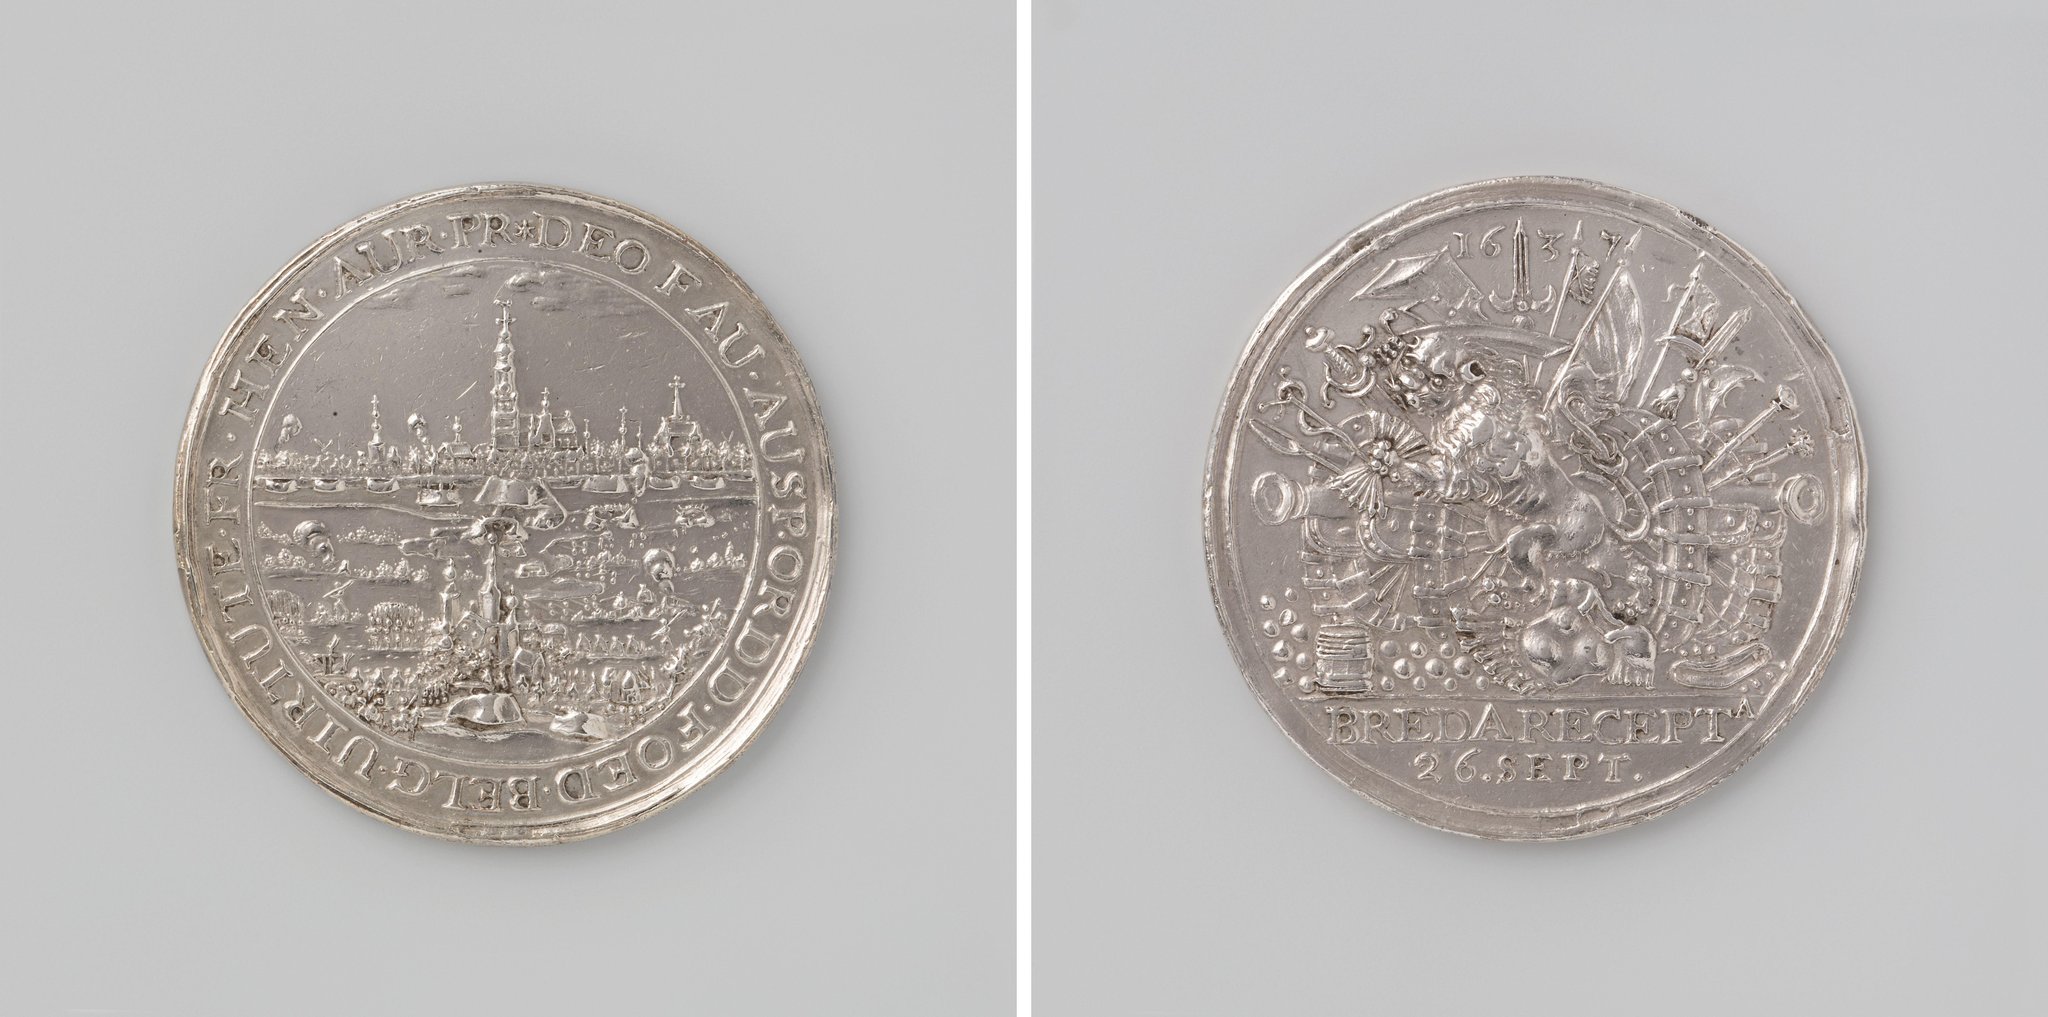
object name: triomfpenning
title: Inname van Breda door Frederik Hendrik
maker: Anonymous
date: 1637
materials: silver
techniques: striking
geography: netherlands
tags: the hague, frederick henry (prince of orange)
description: Zilveren penning. Voorzijde: gezicht op de veroverde stad binnen omschrift. Keerzijde: leeuw met getrokken zwaard en pijenbundel staande voor trophee, bestaande uit stapel wapentuig binnen omschrift